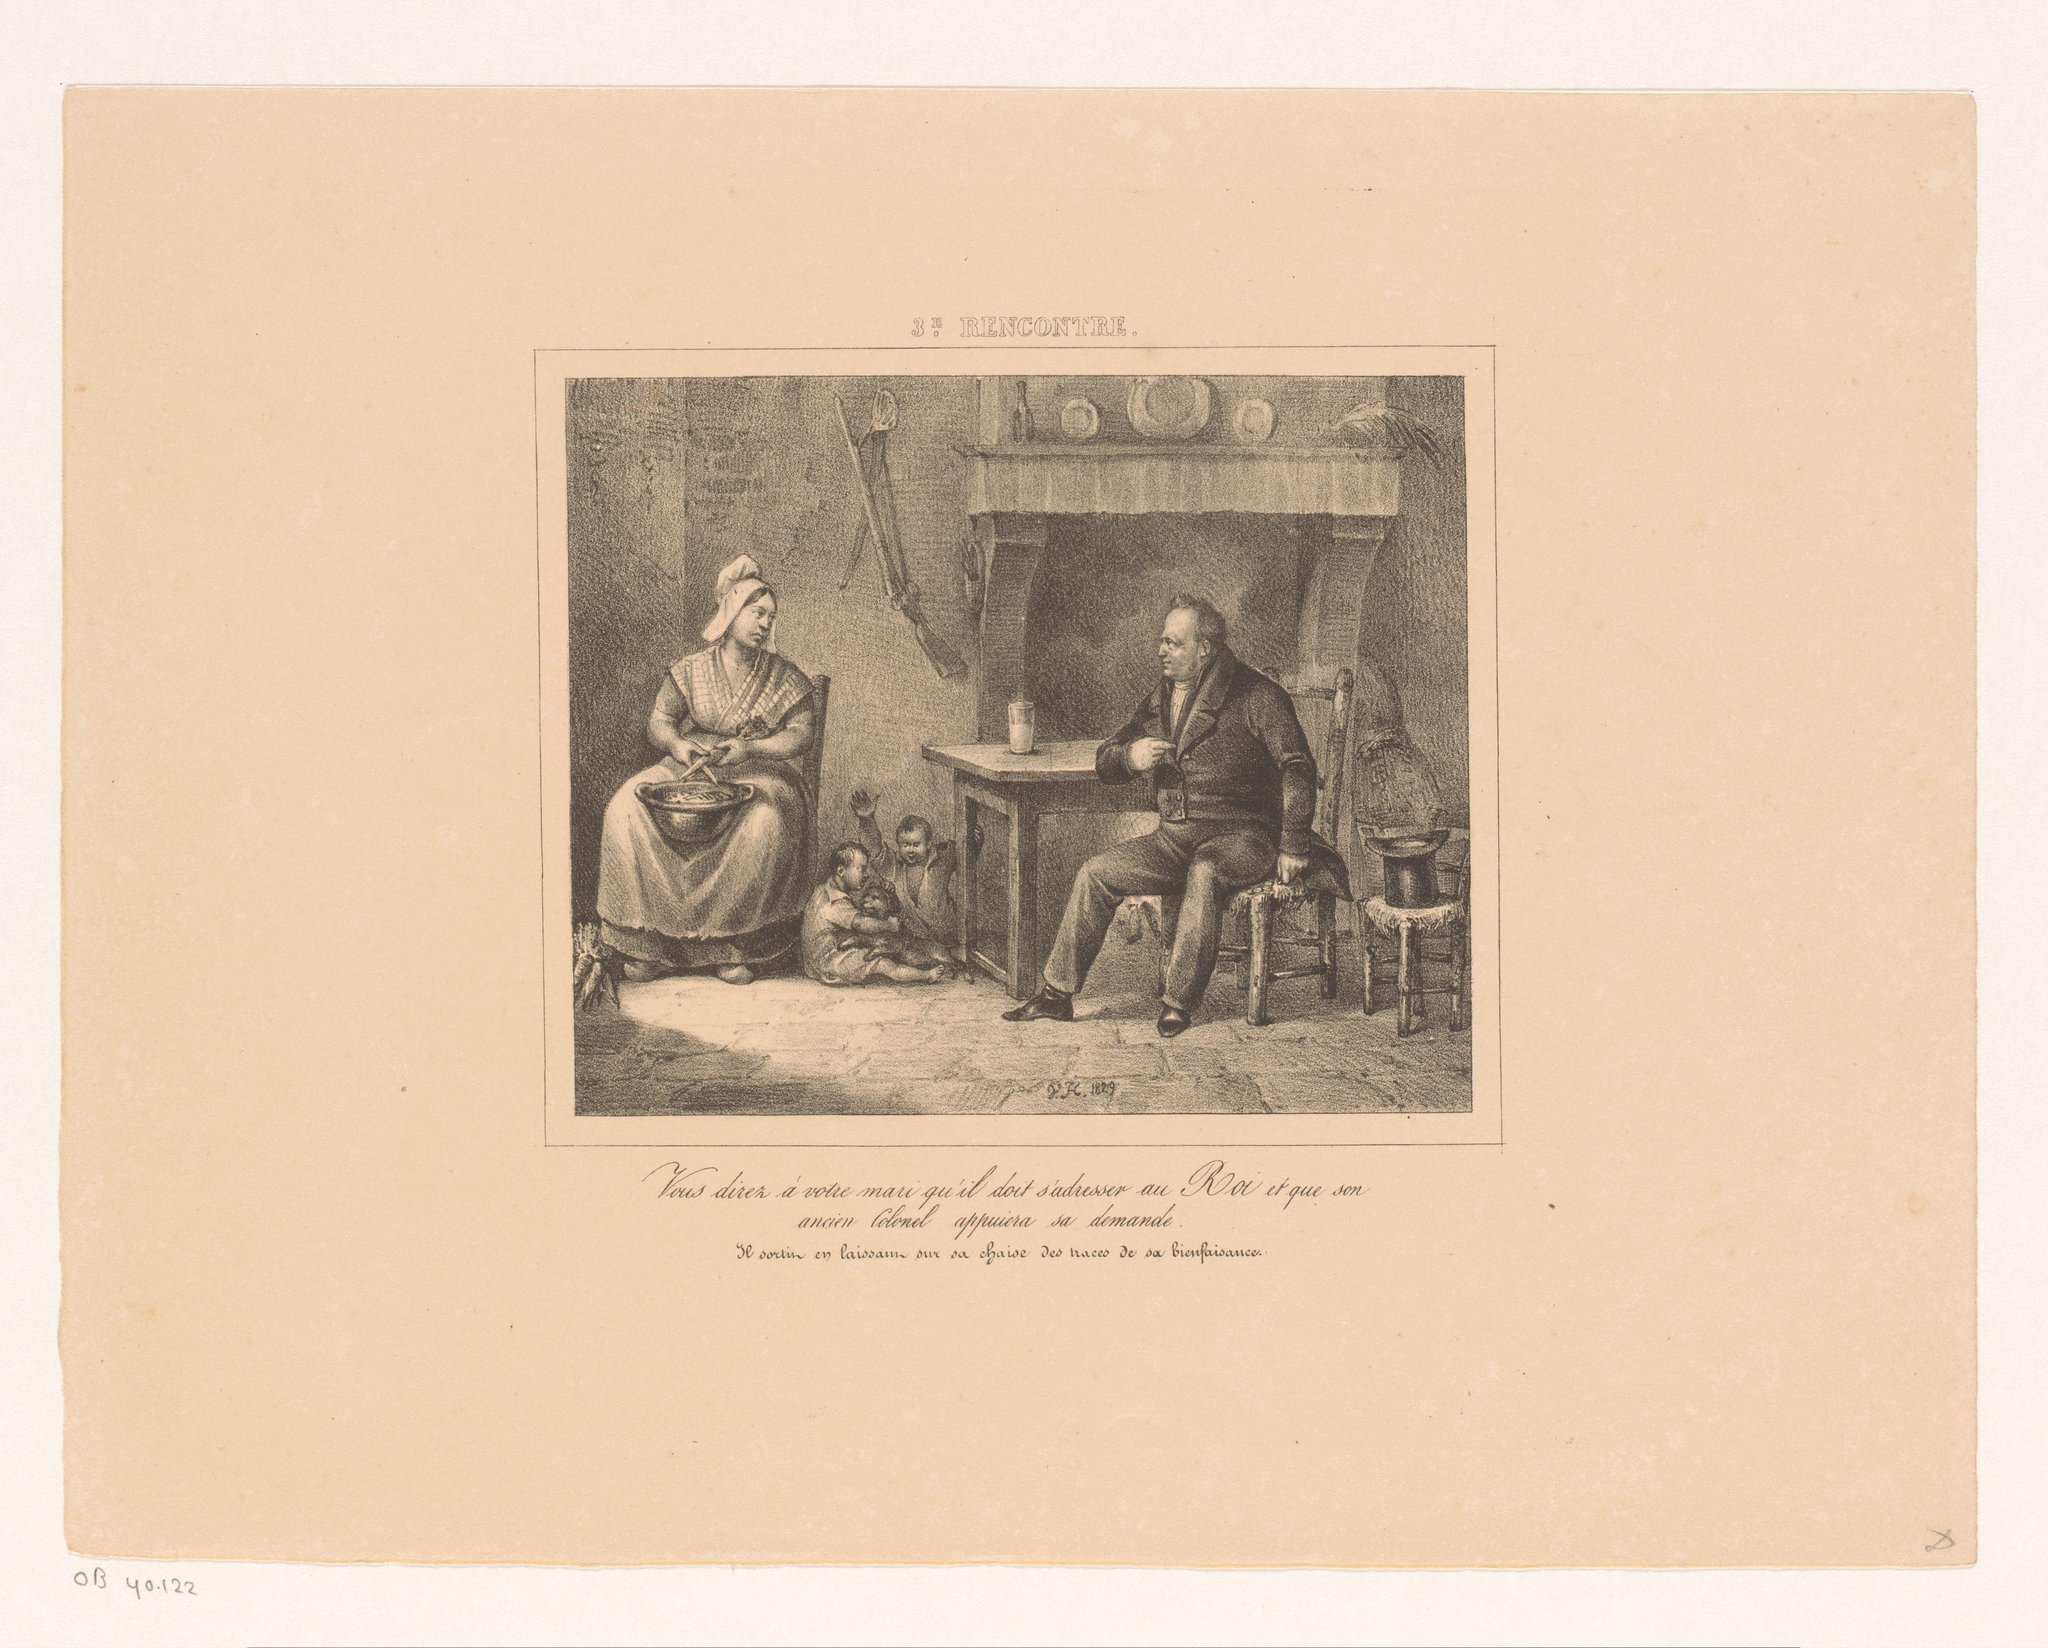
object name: print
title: 3e rencontre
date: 1829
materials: paper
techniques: lithograph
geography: brussels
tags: berlin, william i of the netherlands, ruler in informal contact with his subjects, farmers - aa - female farmer, farmer's wife, interior of the house, mother and child(ren), woman and child(ren) (family group)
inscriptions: collector's mark: Lugt 2228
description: De koning in een eenvoudige boerenwoning sprekend met de boerin. Ondertussen legt hij enkele geldstukken op zijn stoel. Met drieregelig onderschrift.